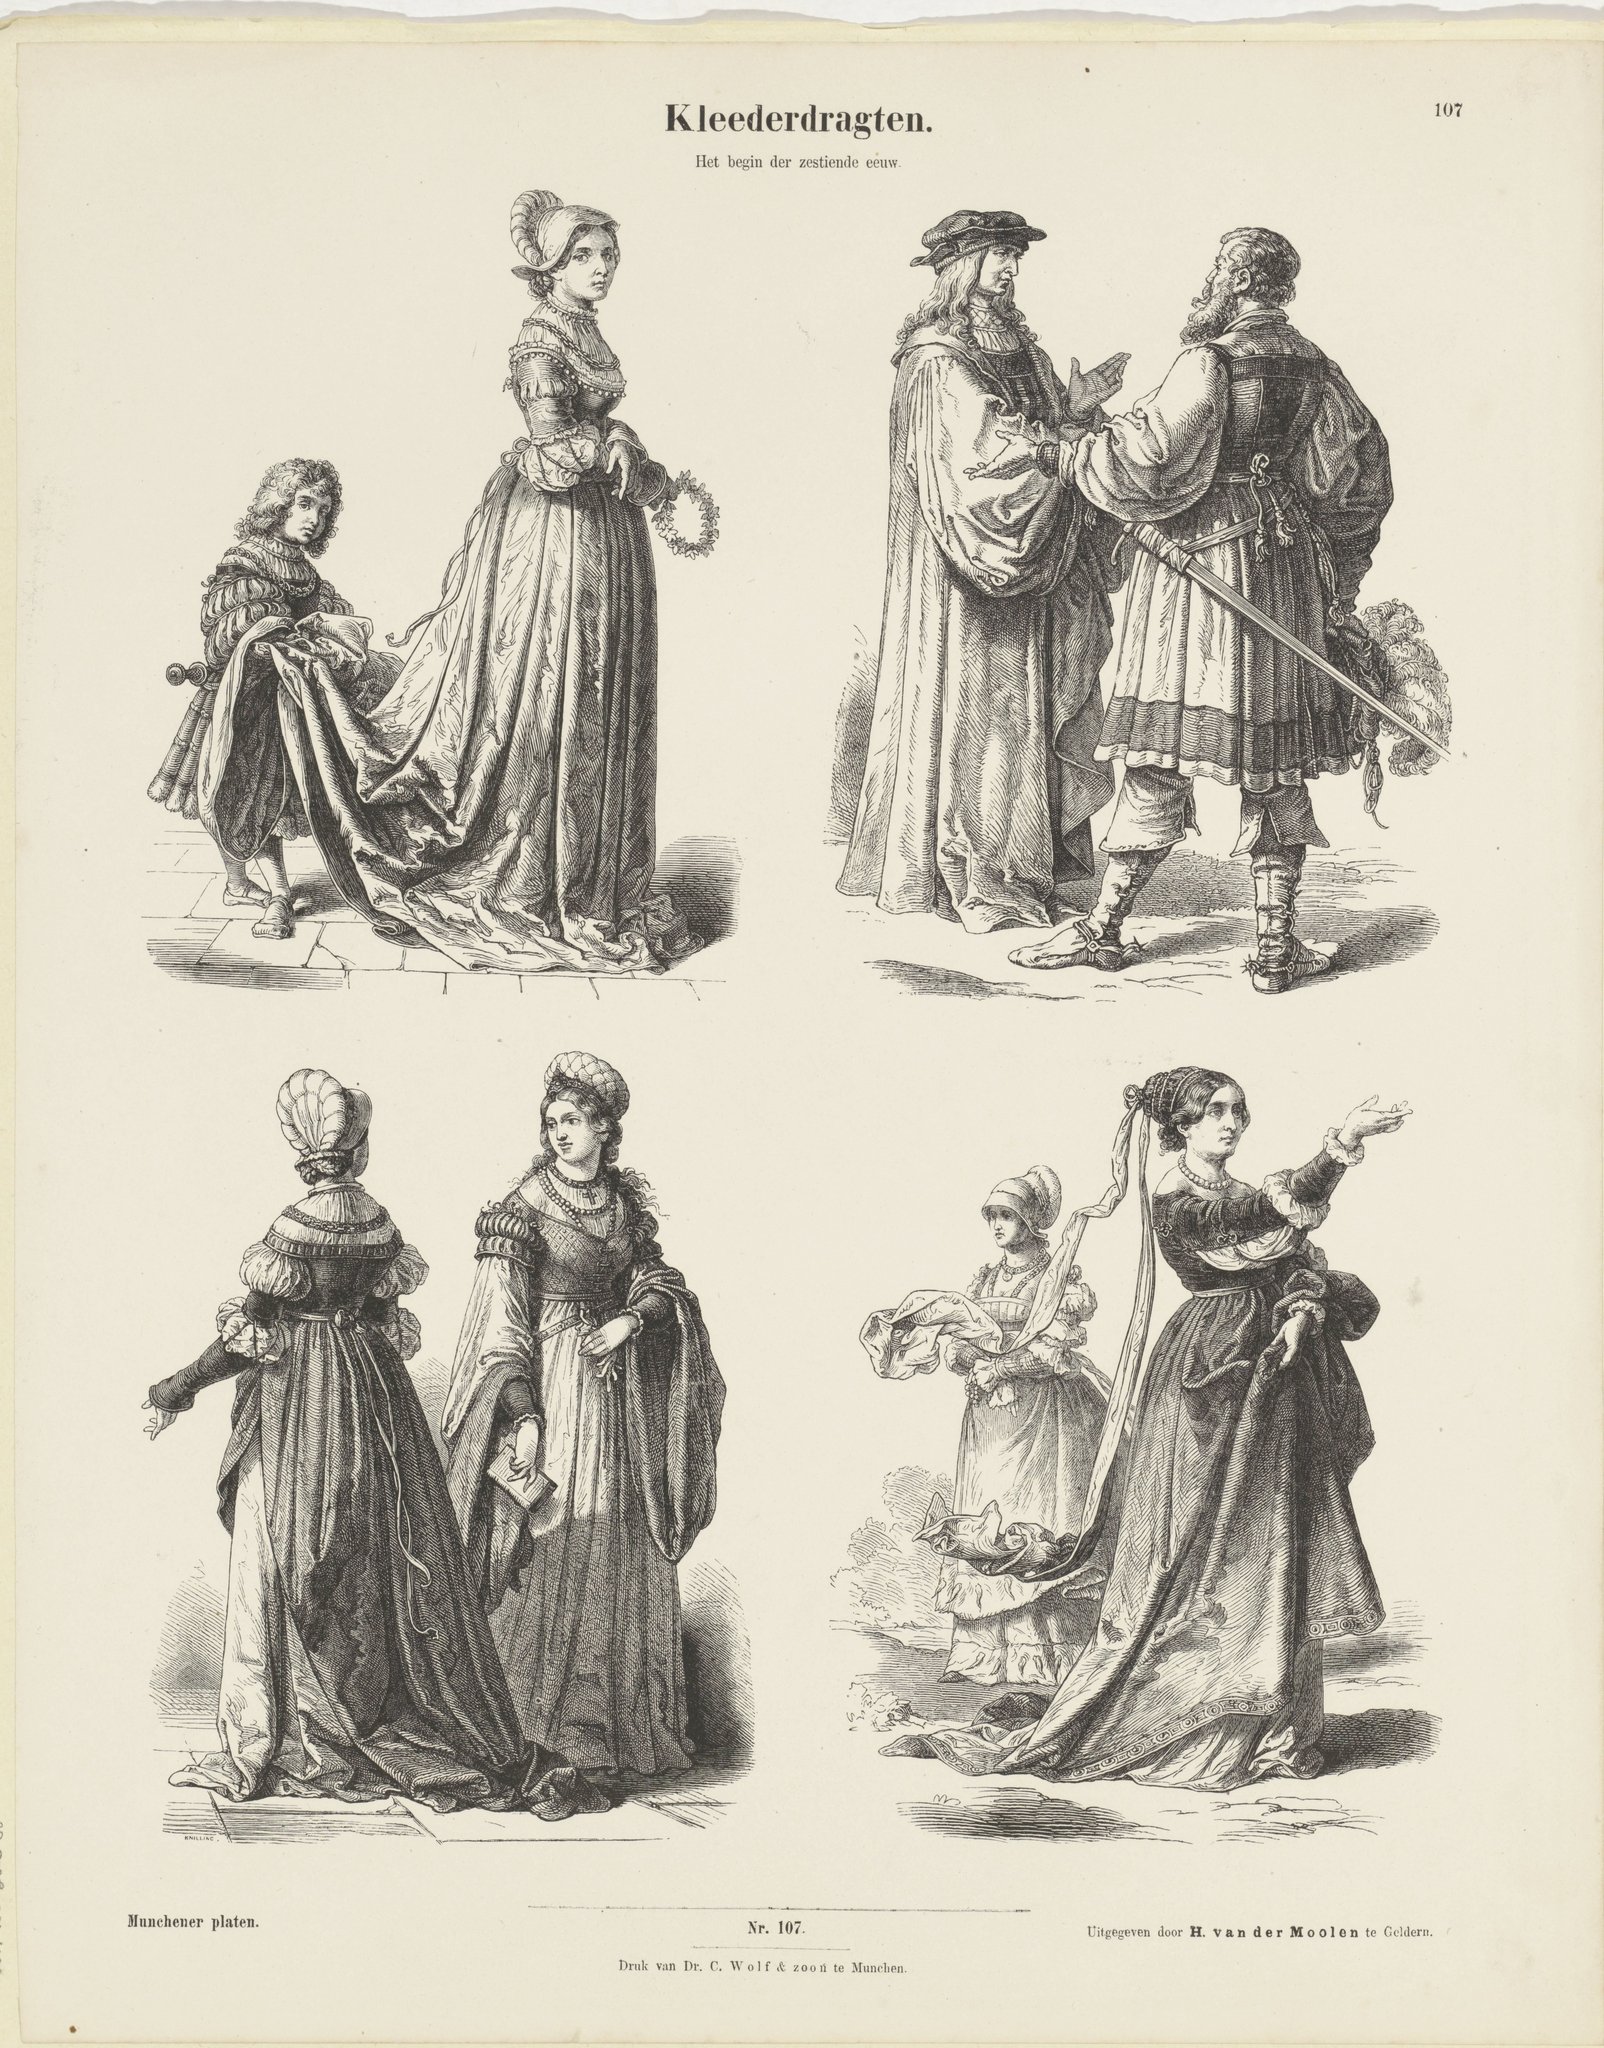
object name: print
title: Munchener platen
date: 1843-1920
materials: paper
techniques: letterpress printing, engraving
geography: munich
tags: historical costume, folk costume, regional costume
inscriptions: collector's mark: Lugt 2760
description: Nederlandse editie van een prent uit de reeks "Munchener platen" uitgegeven door K. Braun & Fr. Schneider te München met het adres van wederverkoper Hermann van der Moolen.